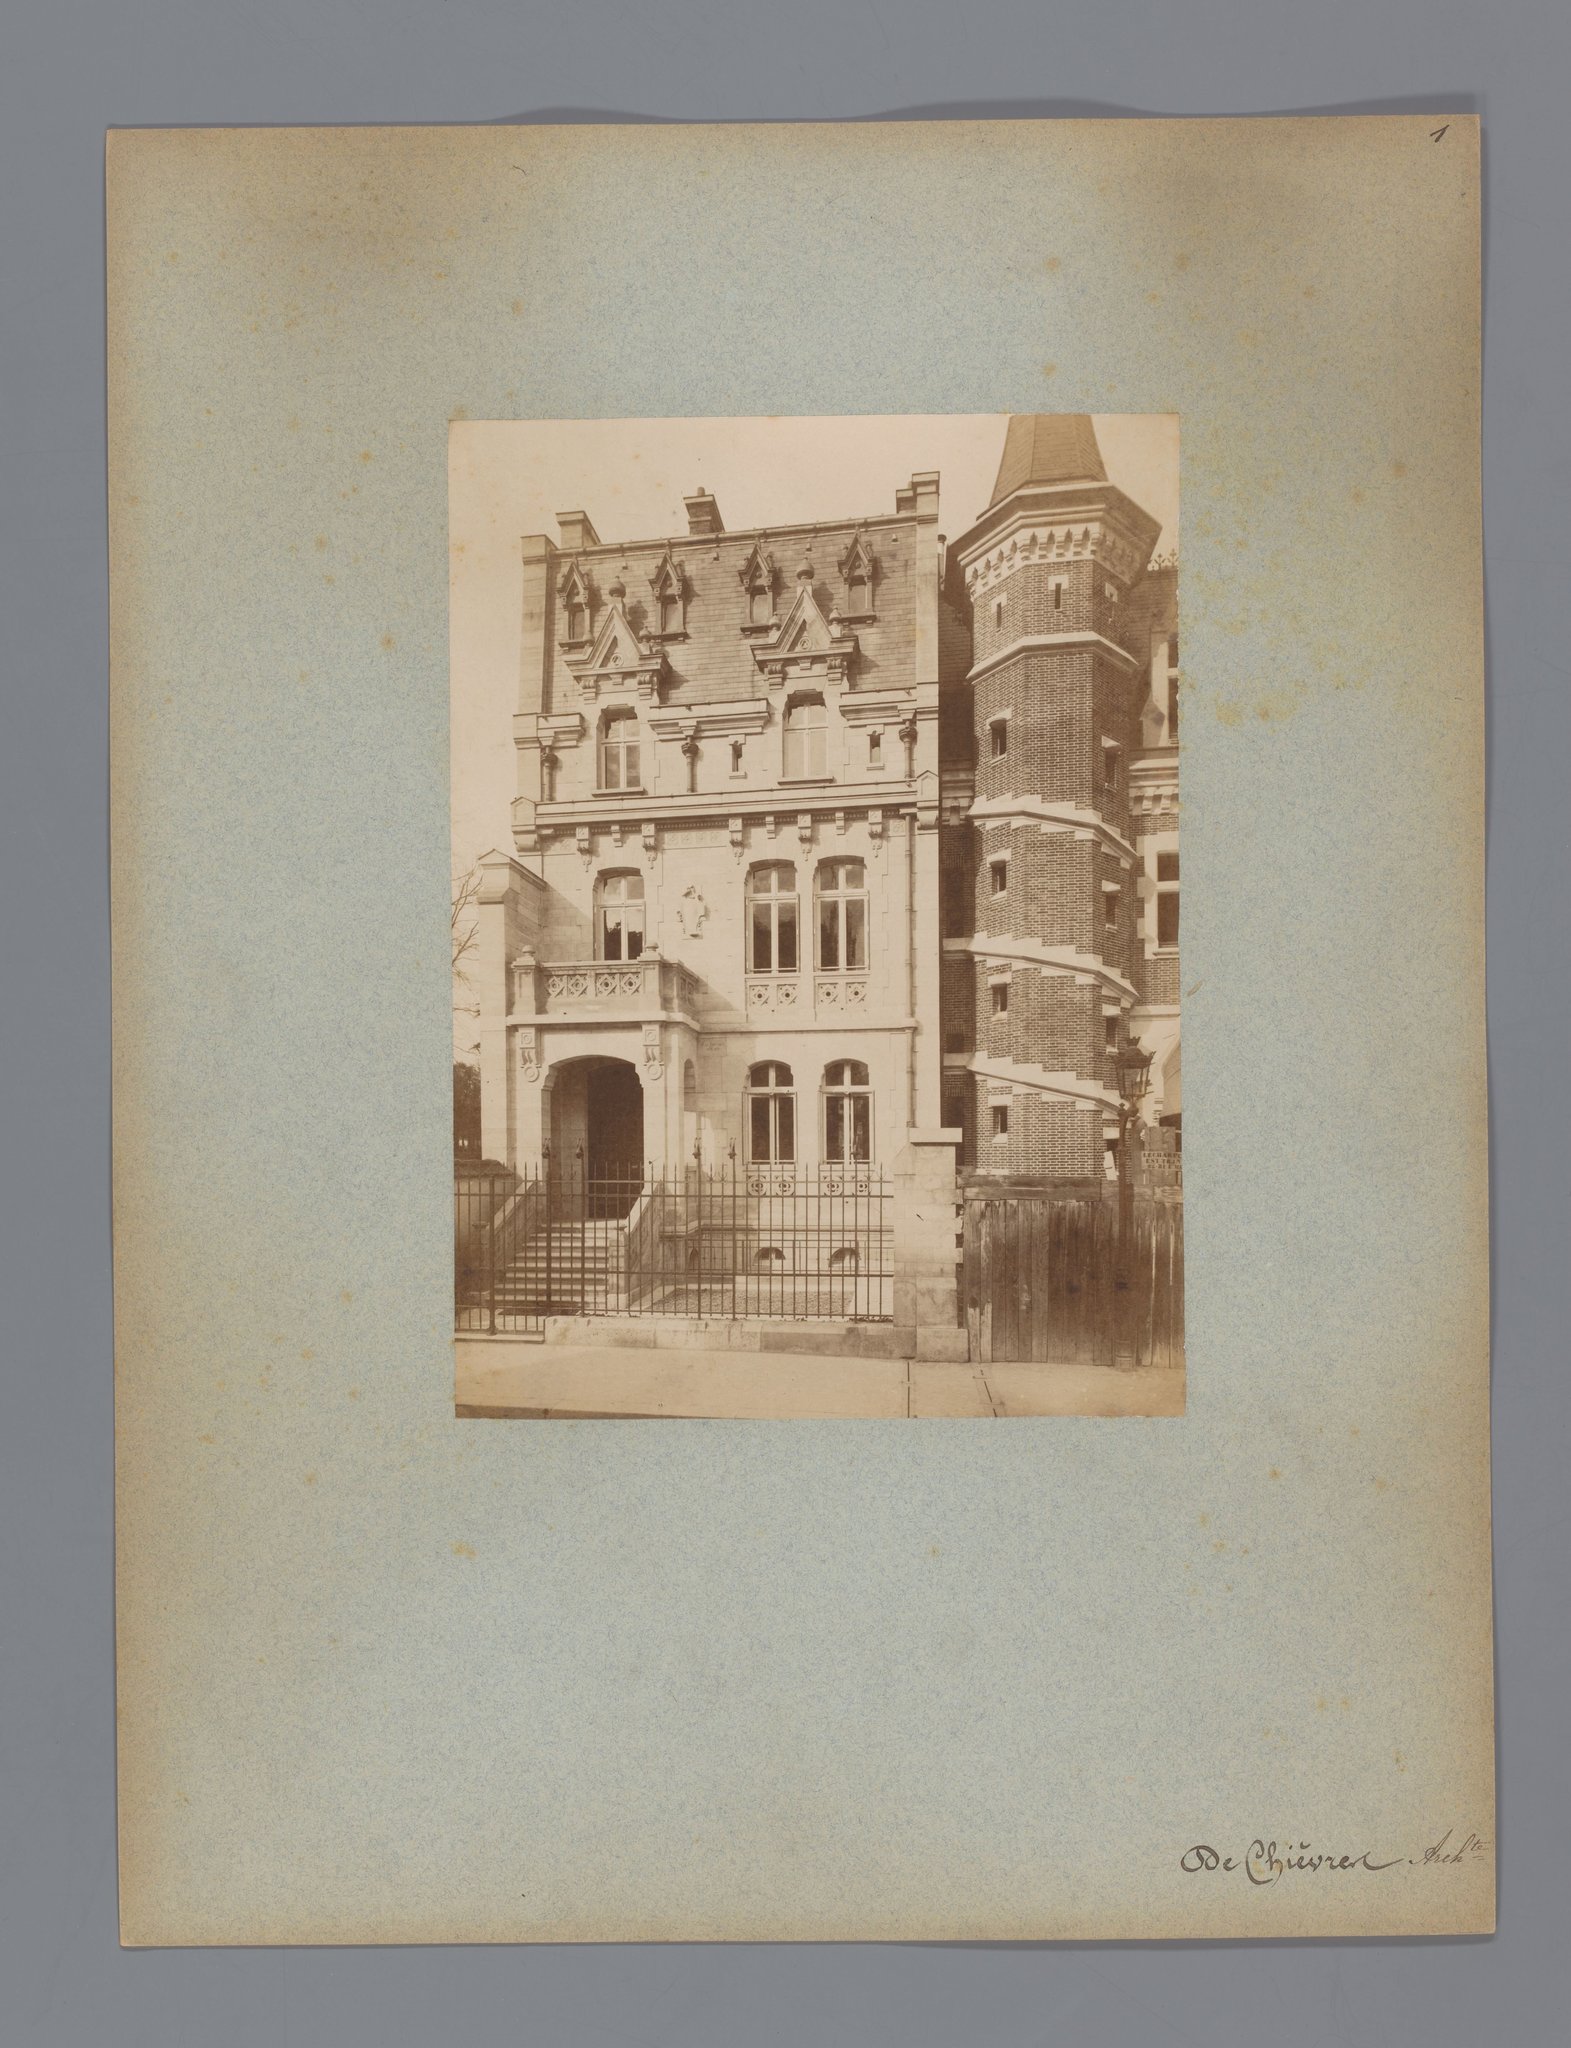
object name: photograph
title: Façade van een gebouw in Parijs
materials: photographic support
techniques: albumen print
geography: paris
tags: façade (of house or building), paris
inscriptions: name: ‘De Chiévre[.] Archte’, number: ‘1’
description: Deze foto maakt deel uit van een omslag met 35 foto's en een titelblad.